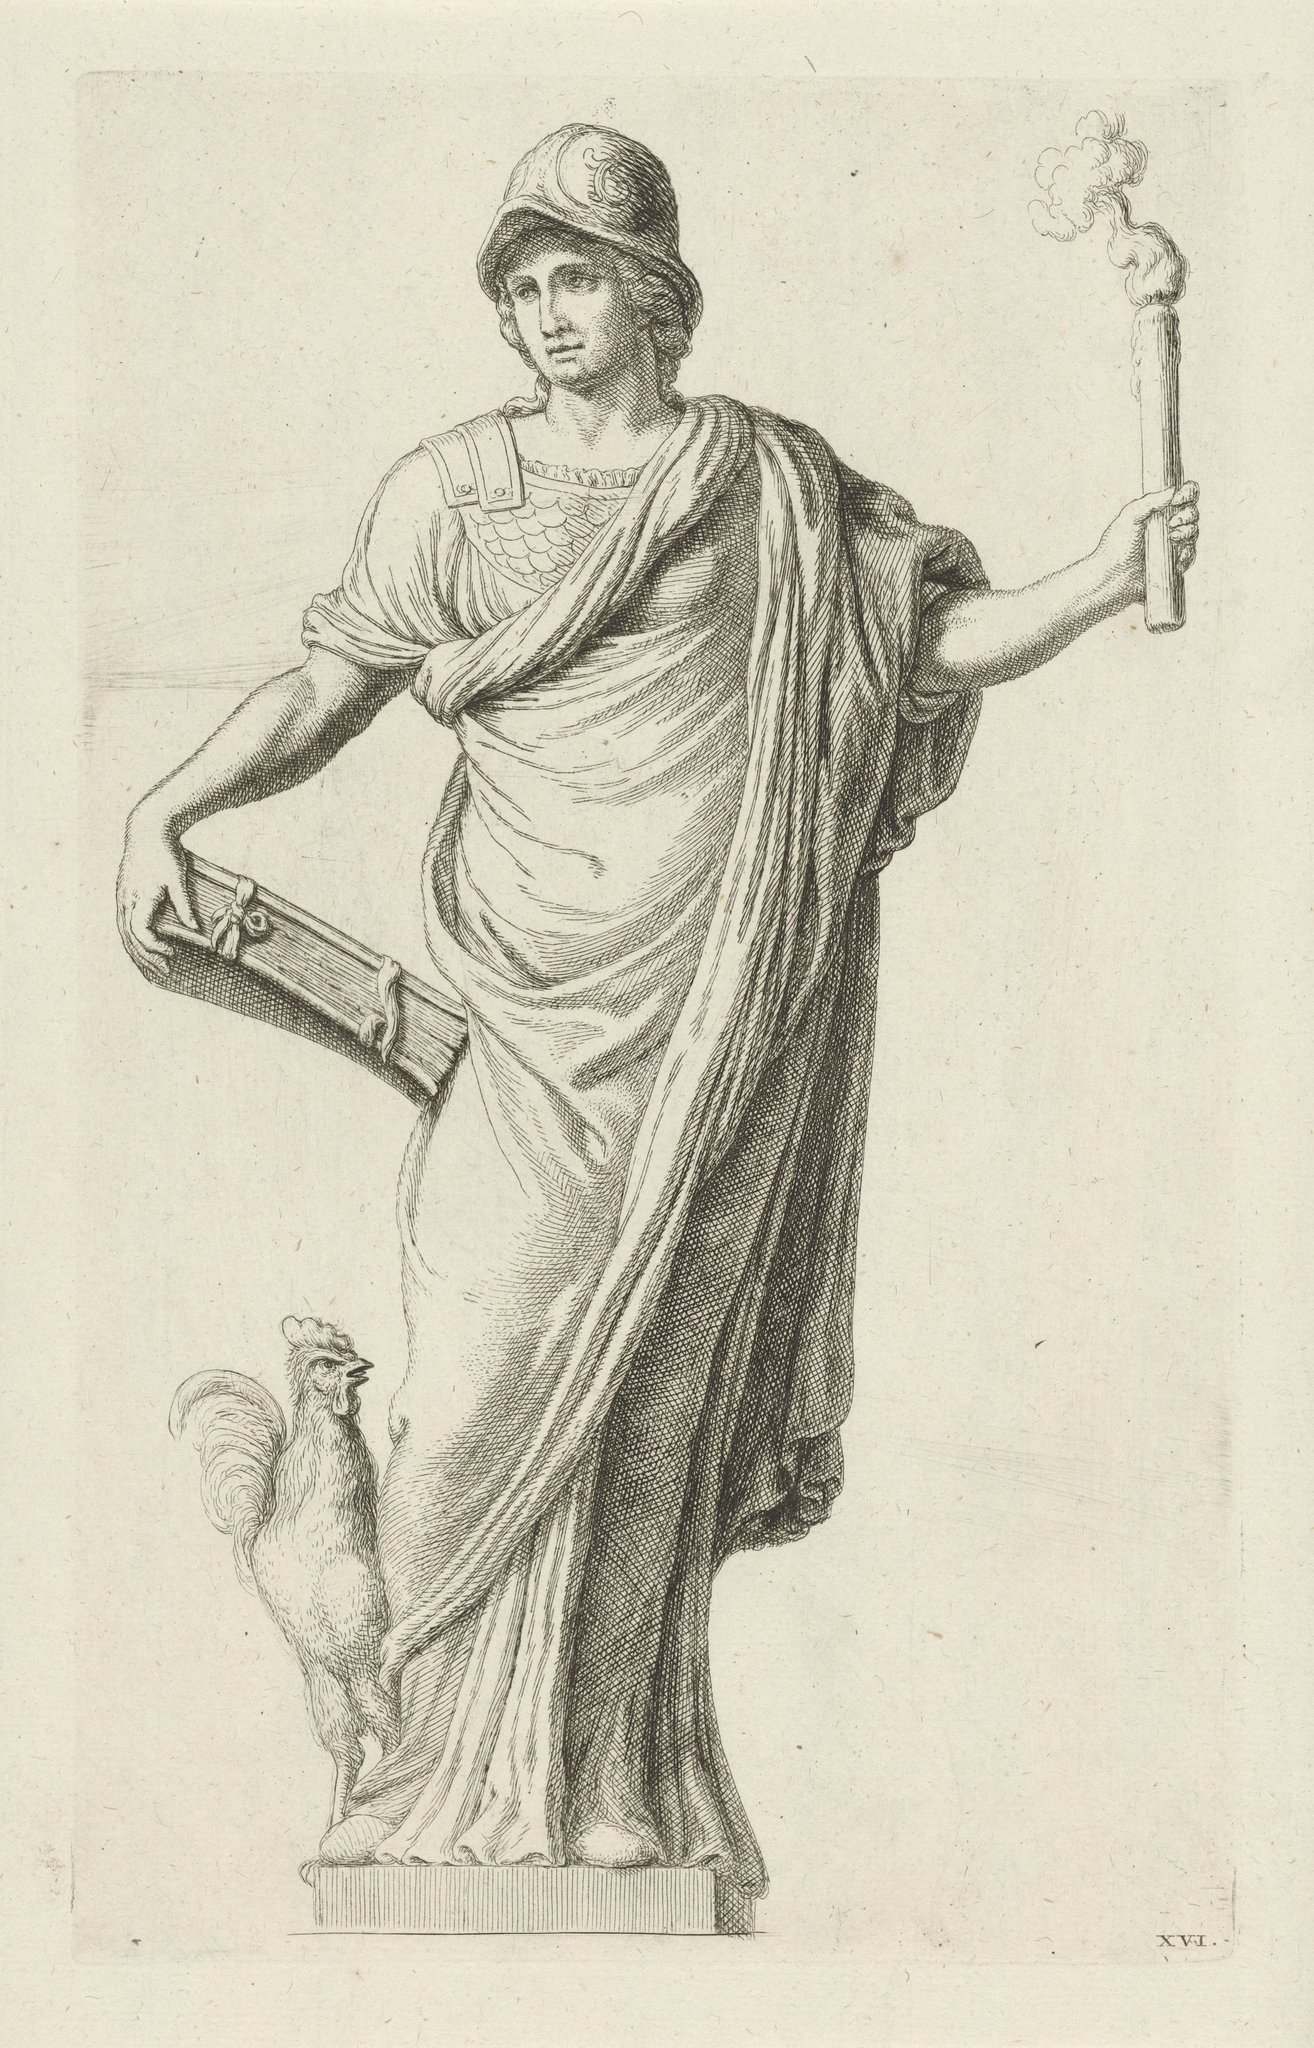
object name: print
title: Beeld van Vigilantia (Waakzaamheid) op de achtergevel van het Stadhuis op de Dam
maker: hubert quellinus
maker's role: print maker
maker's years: 1619-1687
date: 1663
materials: paper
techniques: engraving, etching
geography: amsterdam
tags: attributes of aesculapius: cock, alertness, vigilance; 'guardia', 'vigilanza', 'vigilanza per difendersi & oppugnare altri' (ripa) (+ personification)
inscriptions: collector's mark: Lugt 2228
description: Huidige staat van prent ook gebruikt in: Architecture peinture et sculpture de la Maison de Ville d'Amsterdam, representee en CIX. figures en taille-douce (…). Amsterdam: David Mortier, 1719. En in: Architecture peinture et sculpture de la Maison de Ville d'Amsterdam, representee en CIX. figures en taille-douce (…). Amsterdam: Gerard Valck, 1719. En in: Bouw schilder en beeldhouwkonst, van het Stadhuis te Amsteldam, vertoont in CIX figuuren (…). Amsterdam: Covens & Mortier & Covens Jr., s.a. (1774-1783). Eerdere staat van prent ook gebruikt in: Secunca pars Praecipuarum effigierum ac ornamentorum amplissime Curiae Amstelrodamensis maiori ex parte in cadido marmore effectorum per Artum Quellinium eiusdem Civitatis Statuarium / Het tweede deel Van de voornaemste Statuen ende Cieraten van 't konst-rijcke Stadt-huys van Amstelredam 'tmeeste in Marmer gemaeckt door Artus Quellinus Beelthouwer der voorseyde Stadt. Amsterdam: Artus Quellinus (I), 1663. En in: Secunca pars Praecipuarum effigierum ac ornamentorum amplissime Curiae Amstelrodamensis maiori ex parte in cadido marmore effectorum per Artum Quellinium eiusdem Civitatis Statuarium / Het tweede deel Van de voornaemste Statuen ende Cieraten van 't konst-rijcke Stadt-huys van Amstelredam 'tmeeste in Marmer gemaeckt door Artus Quellinus Beelthouwer der voorseyde Stadt. Amsterdam: Frederik de Wit, 1668.